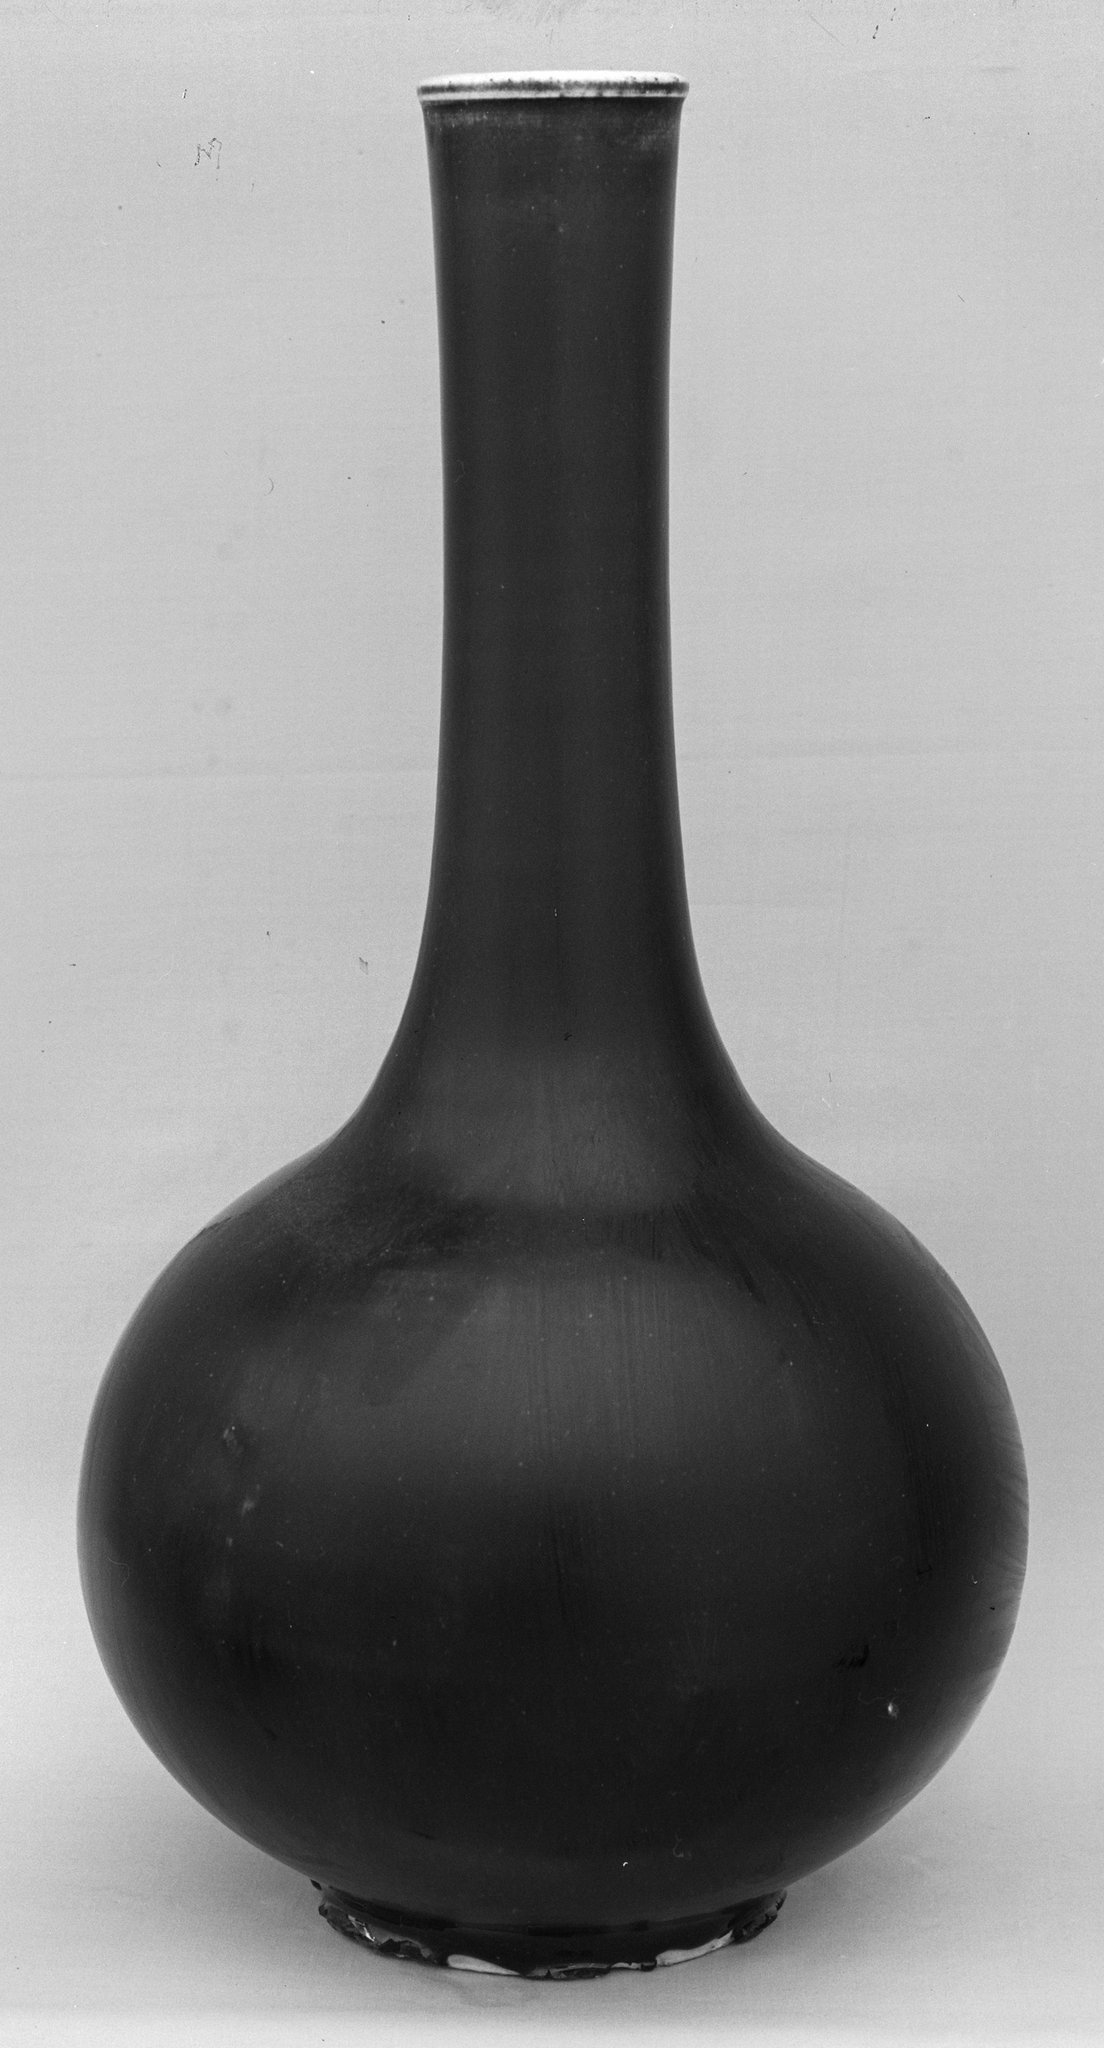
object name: bottle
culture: chinese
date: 1662-1722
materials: glaze, porcelain